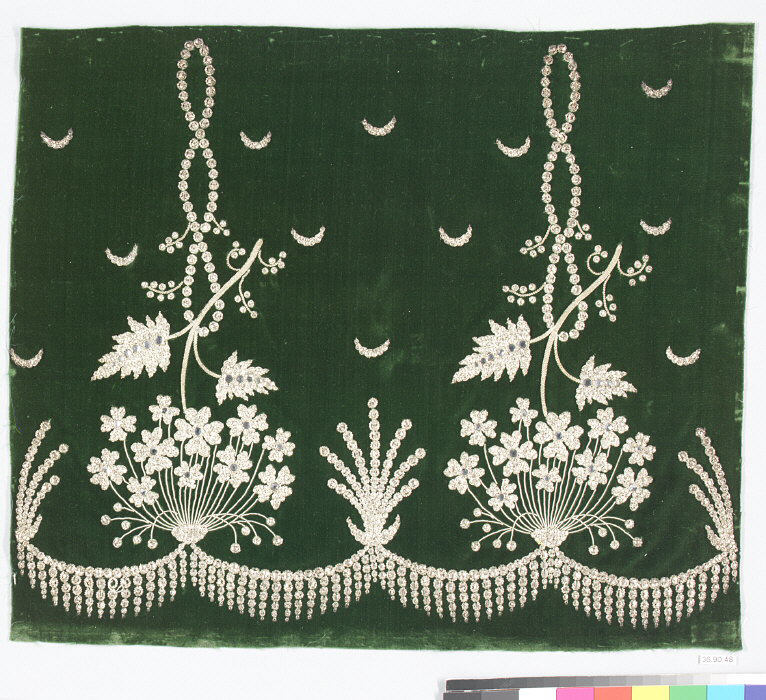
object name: border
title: Dress border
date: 1801-1833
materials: metal thread, silk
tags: flowers